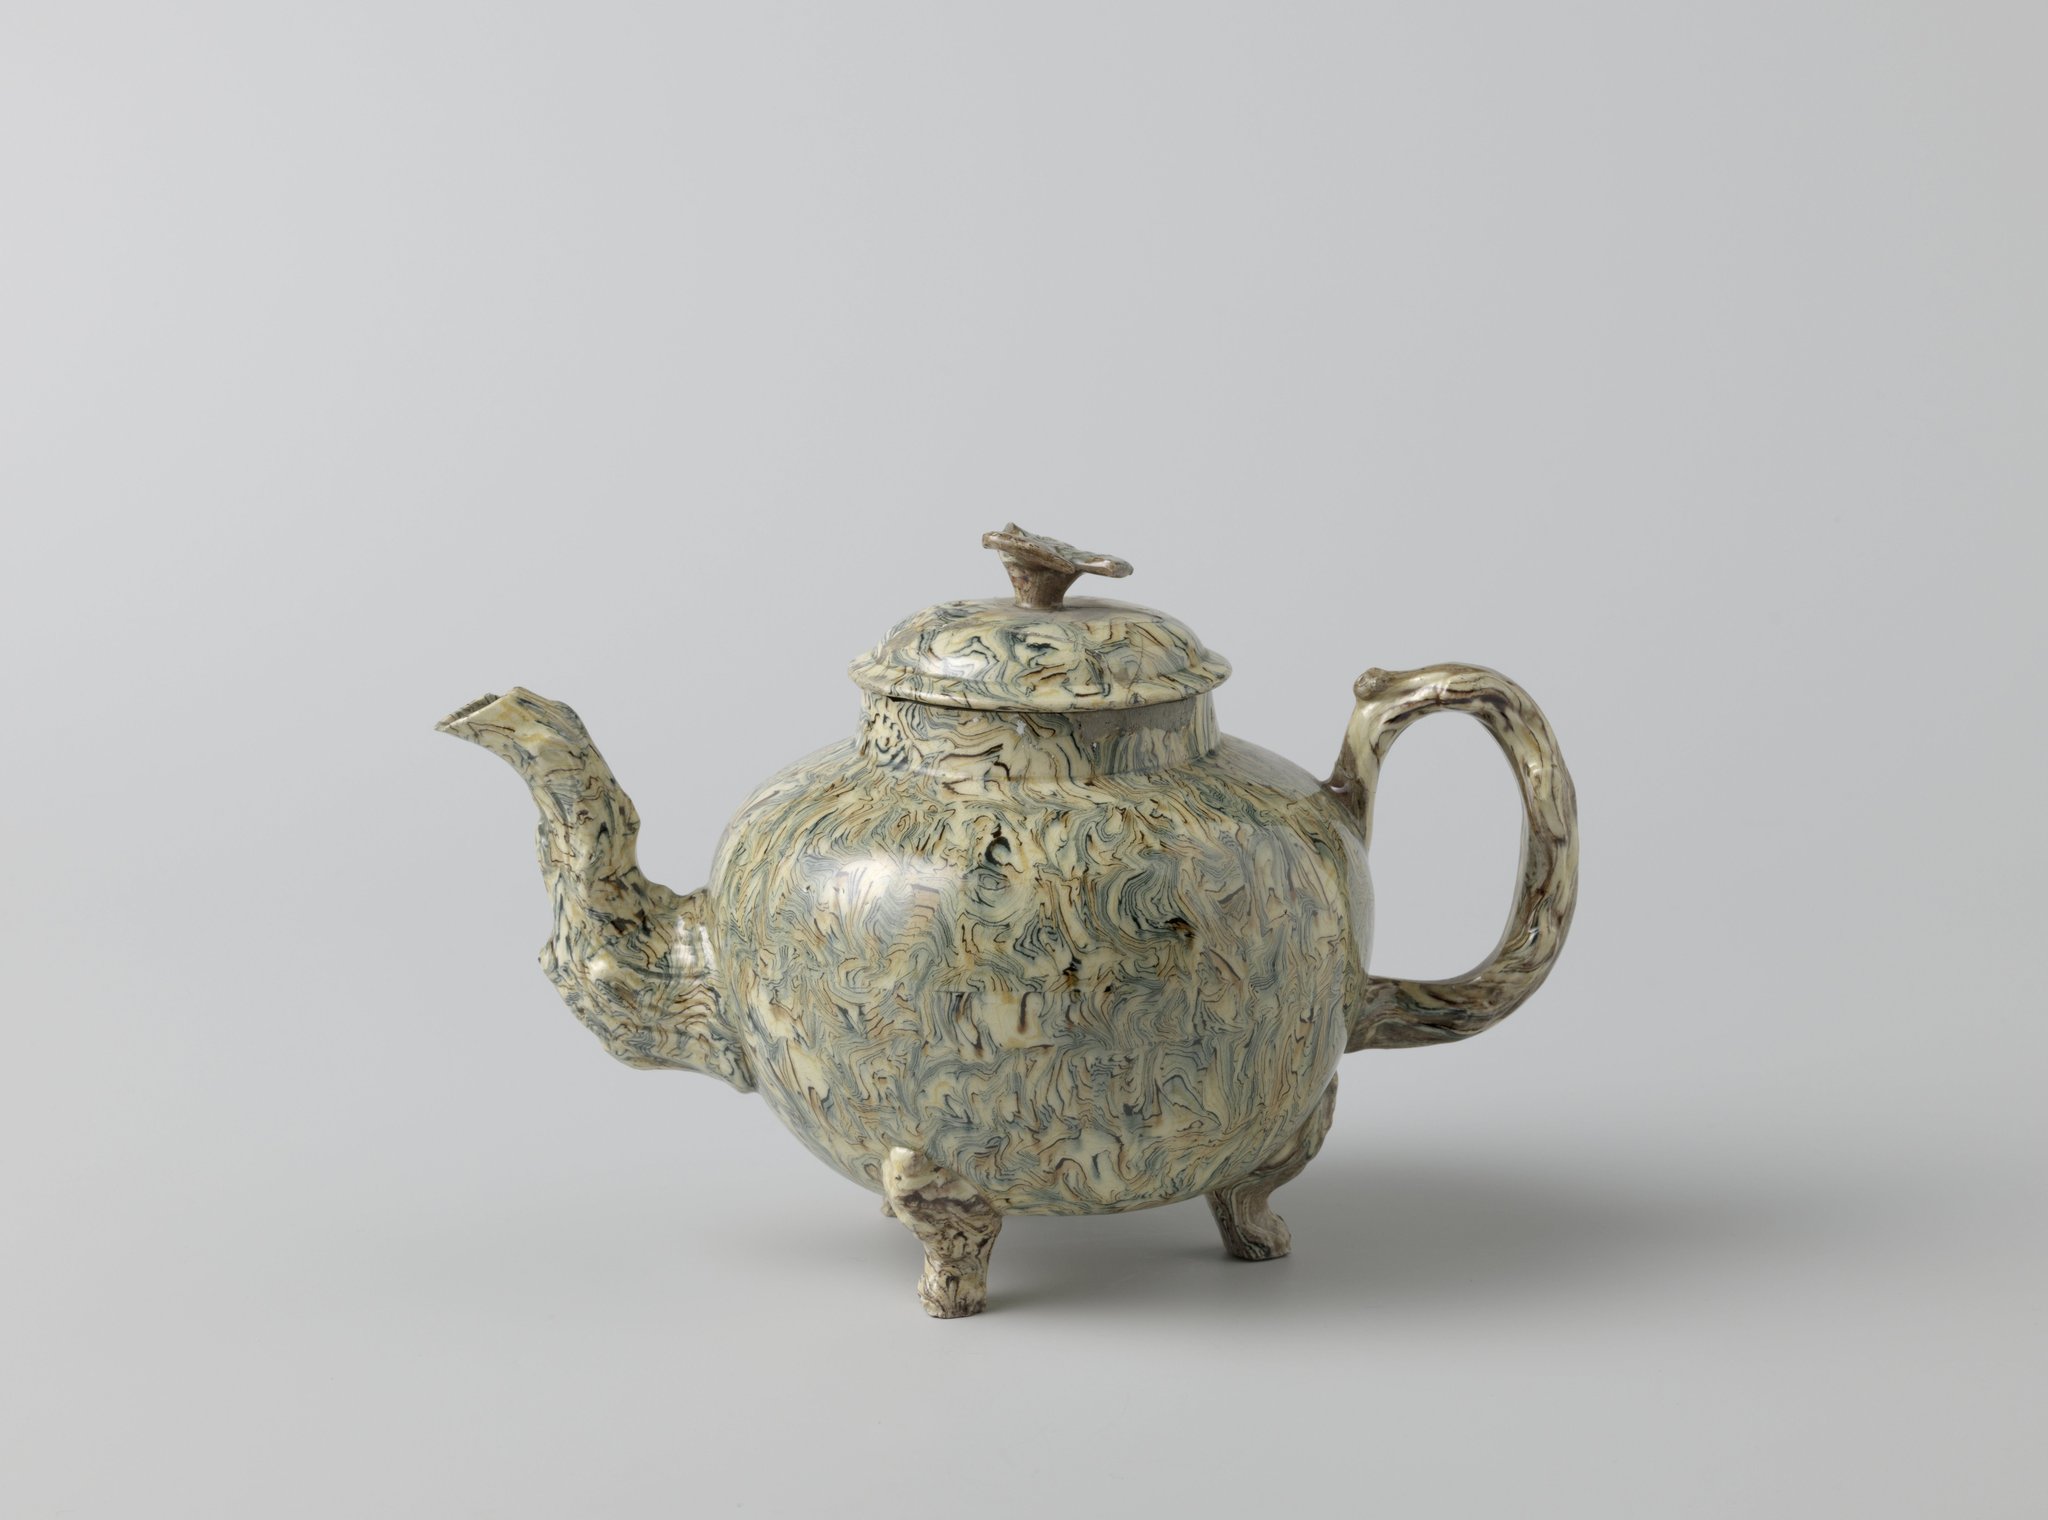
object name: teapot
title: Theepot van hardgebakken aardewerk; Whieldon ware, agate ware ("kievit")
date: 1750-1765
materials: earthenware, glaze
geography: fenton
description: Teapot. Solid agate ware. England, Staffordshire, c. 1750 - 1765.